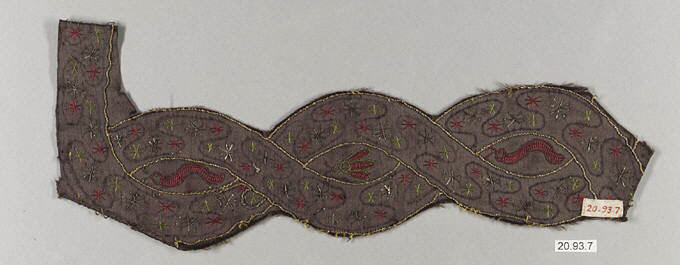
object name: piece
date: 1567-1600